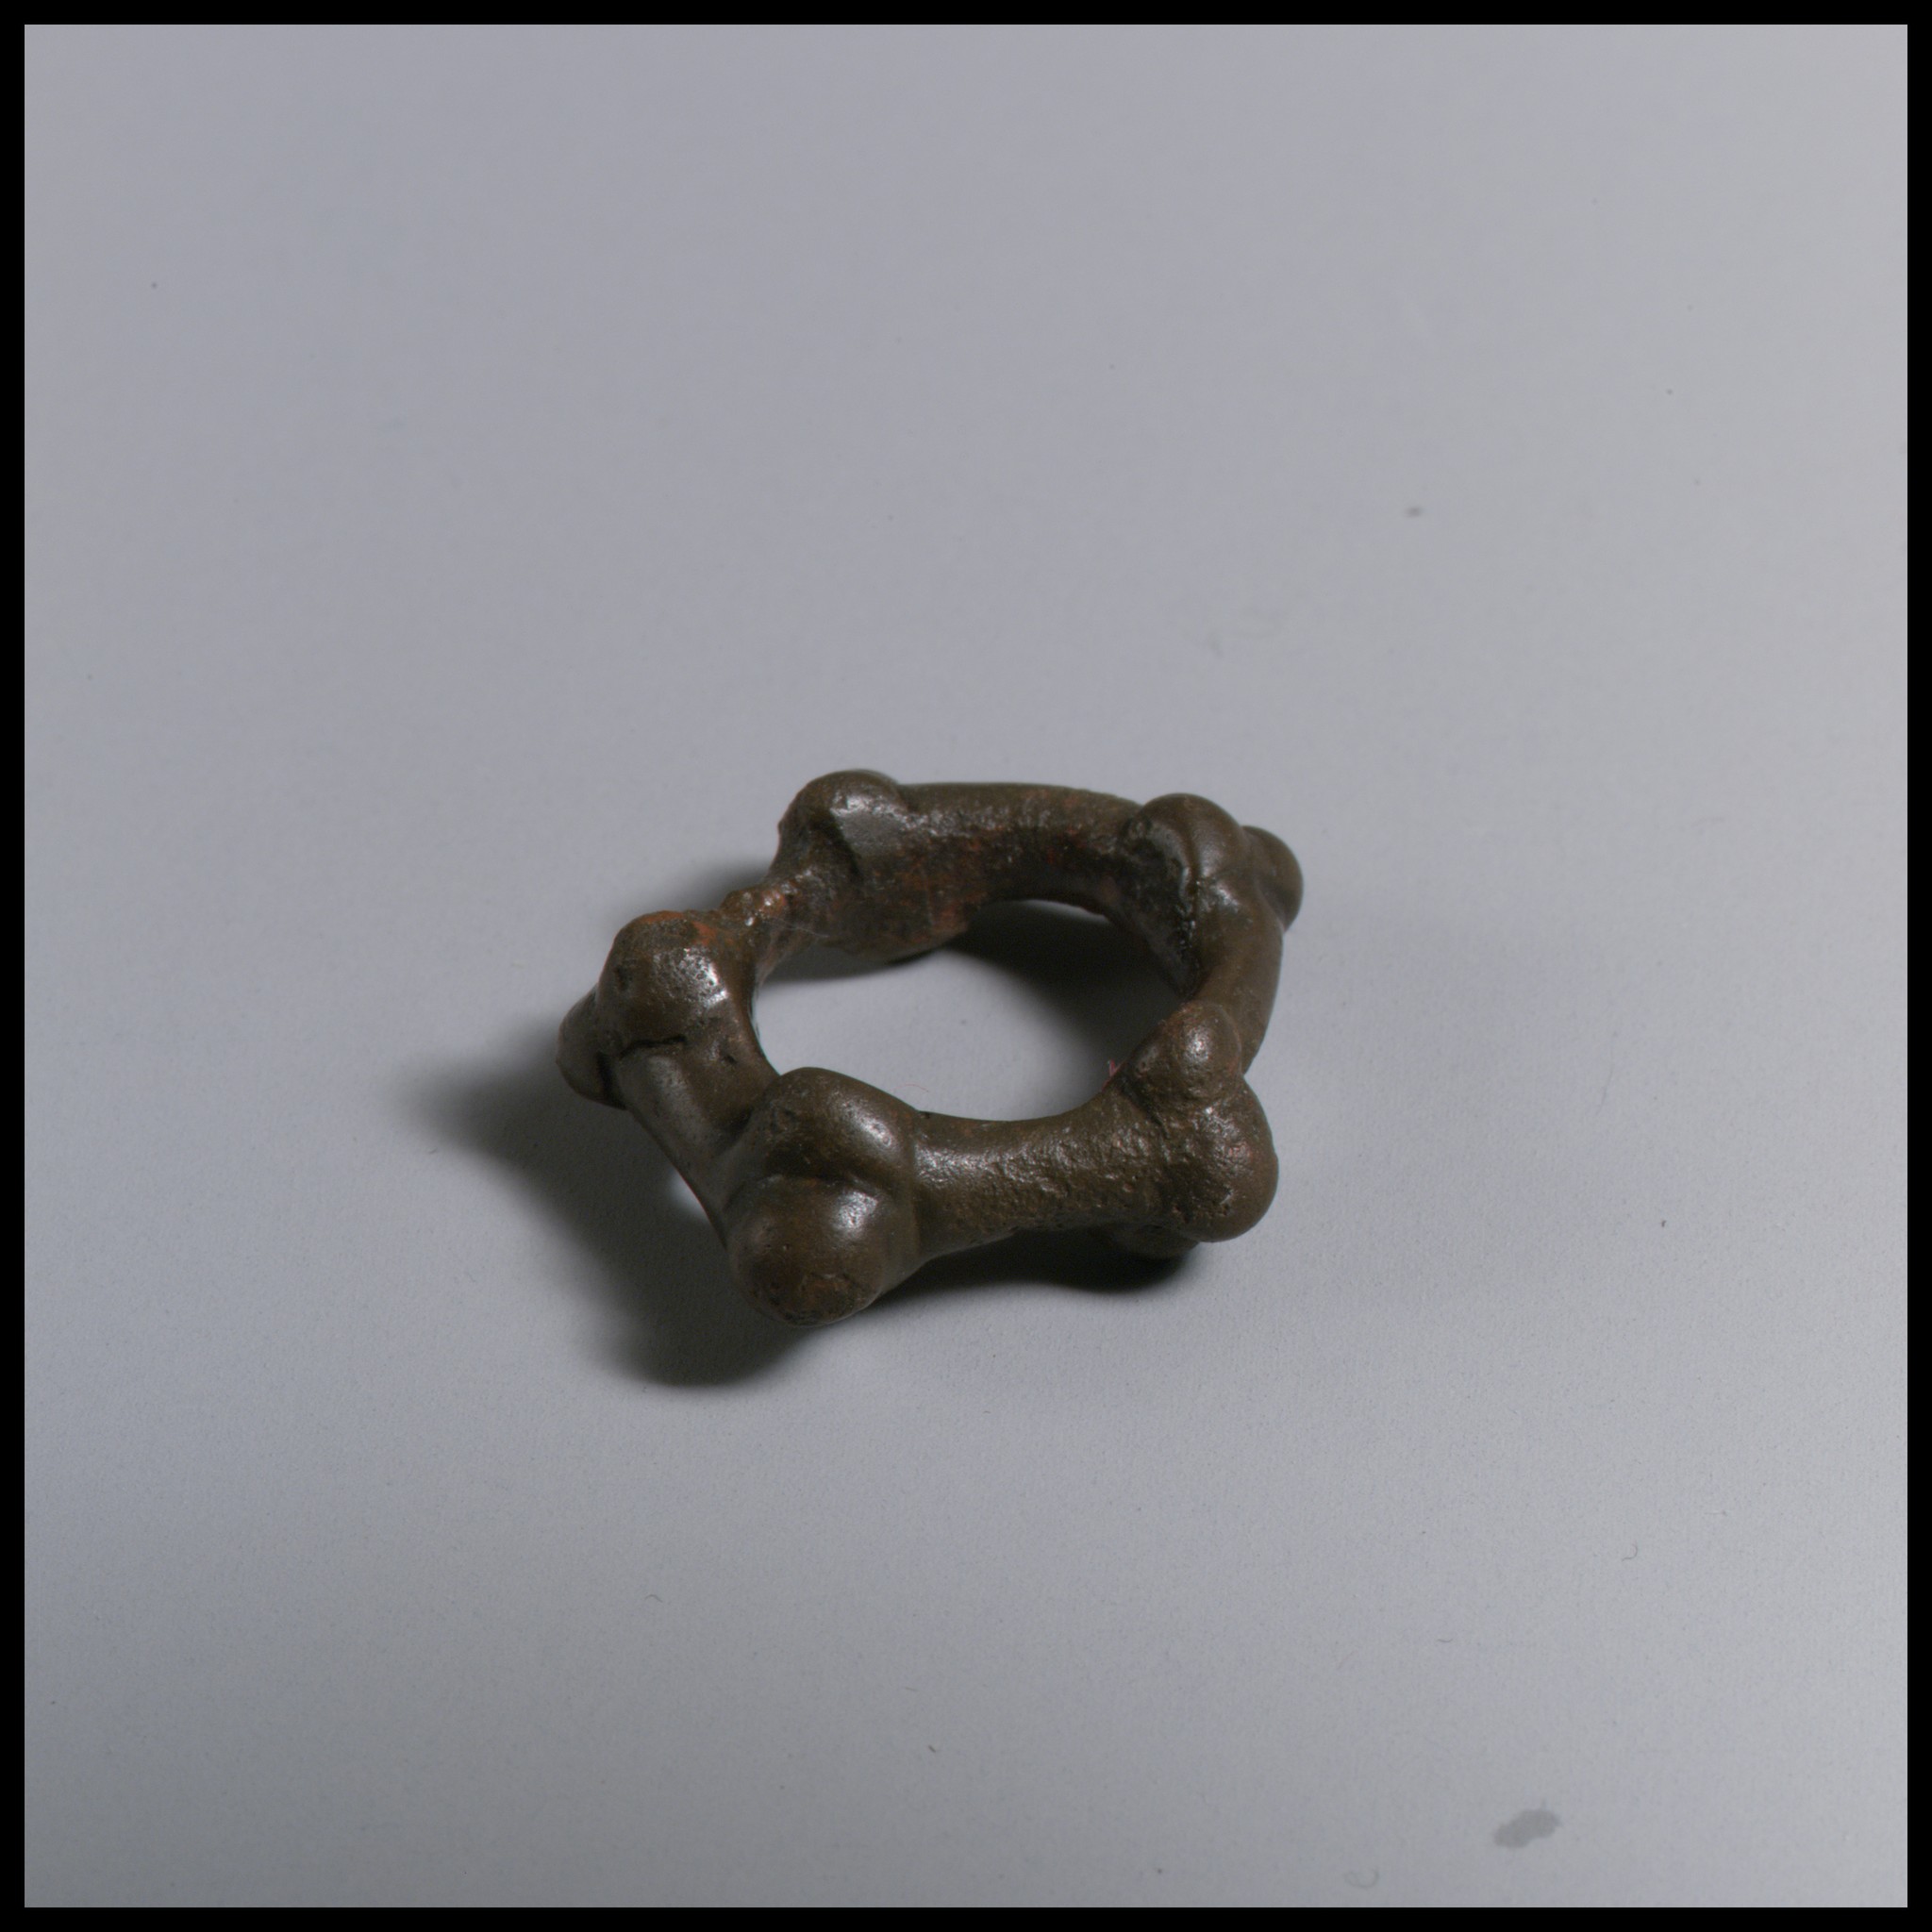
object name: ring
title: Bronze ring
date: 7000 BCE-330 CE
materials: bronze